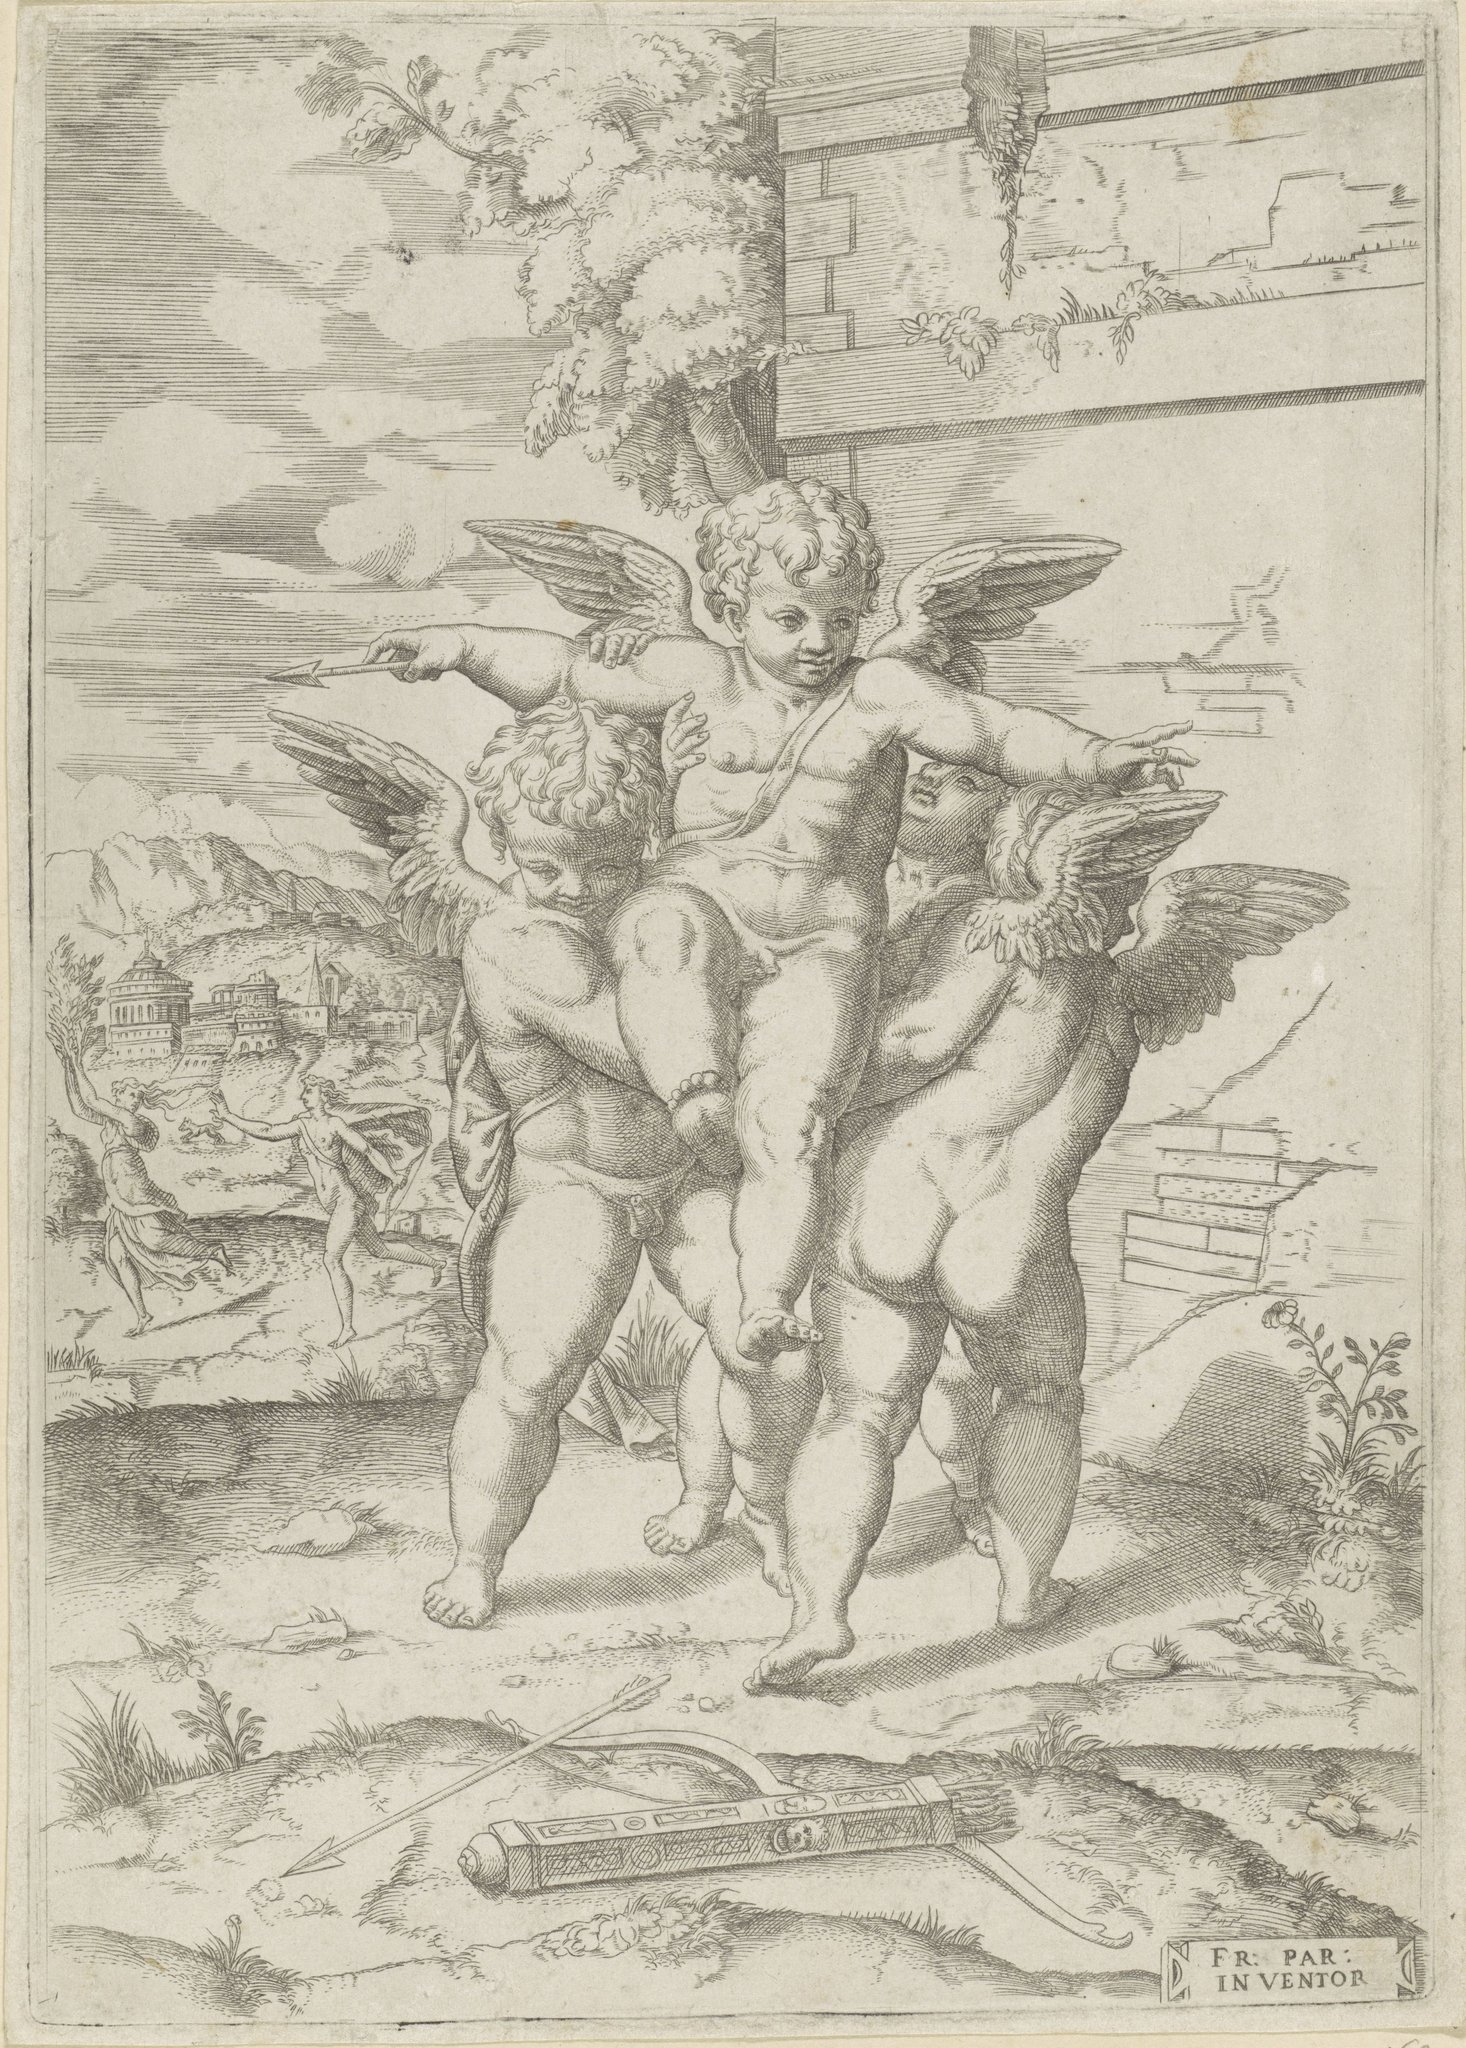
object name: print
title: Amor en drie putti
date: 1501-1580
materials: paper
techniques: etching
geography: italy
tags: apollo pursuing the nymph daphne (as yet not metamorphosed), (story of) cupid, amor (eros), cupids: 'amores', 'amoretti', 'putti'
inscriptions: collector's mark: Lugt 240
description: Amor, met een pijl in zijn rechterhand, wordt opgehouden door drie gevleugelde putti. Op de voorgrond liggen een boog en een pijlenkoker. Op de achtergrond een landschap met Apollo en Daphne.